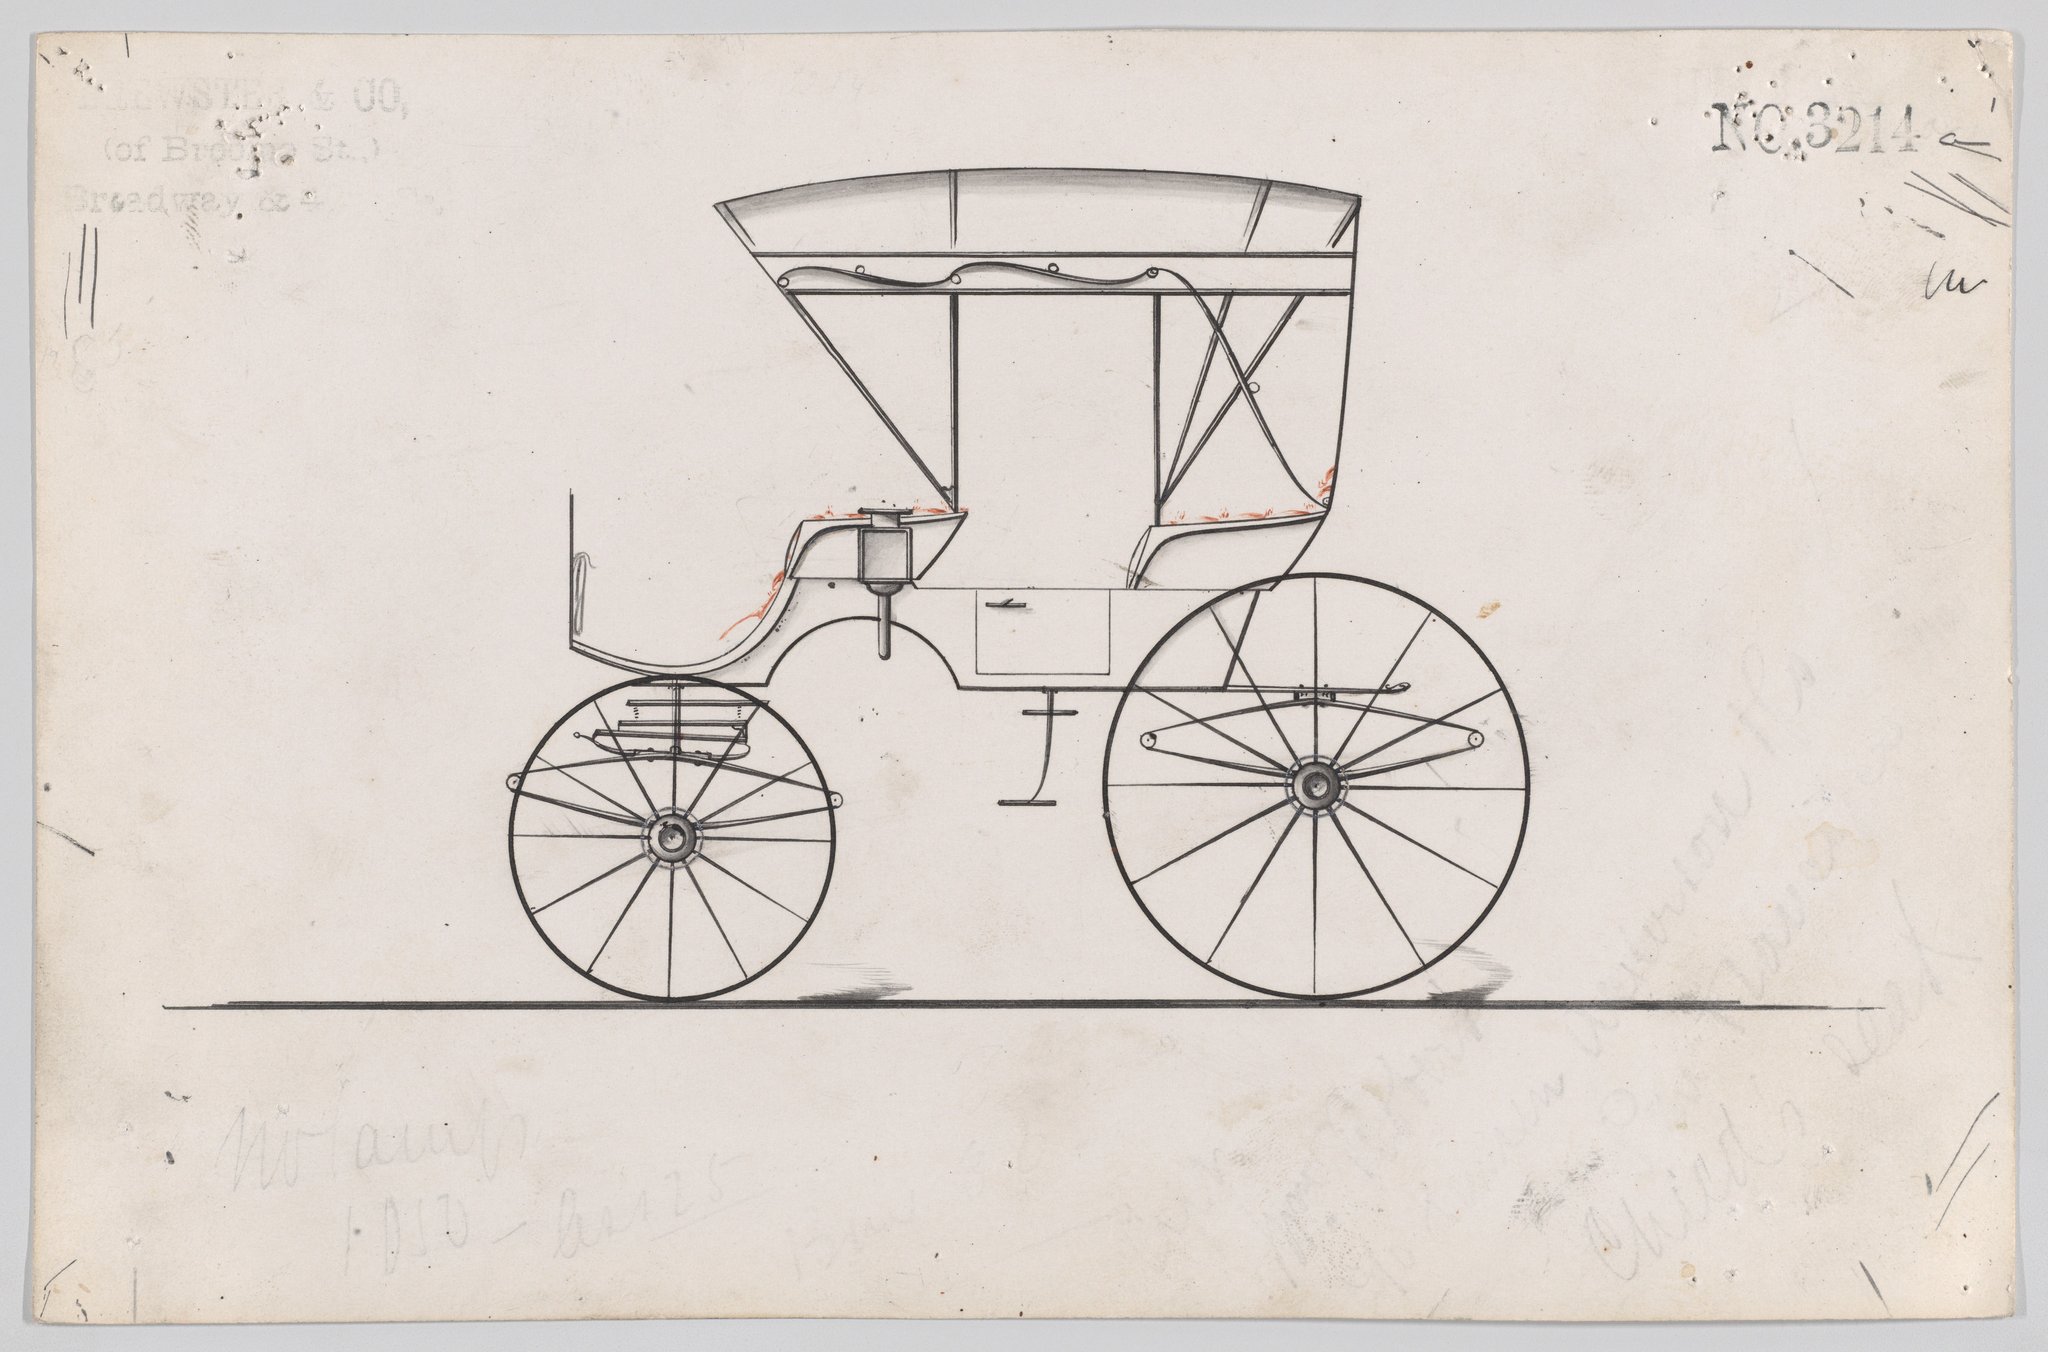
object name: drawing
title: Design for Park Phaeton, no. 3214a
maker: brewster & co.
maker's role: manufacturer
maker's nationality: american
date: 1876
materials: gouache, ink, watercolor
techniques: pen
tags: carriages